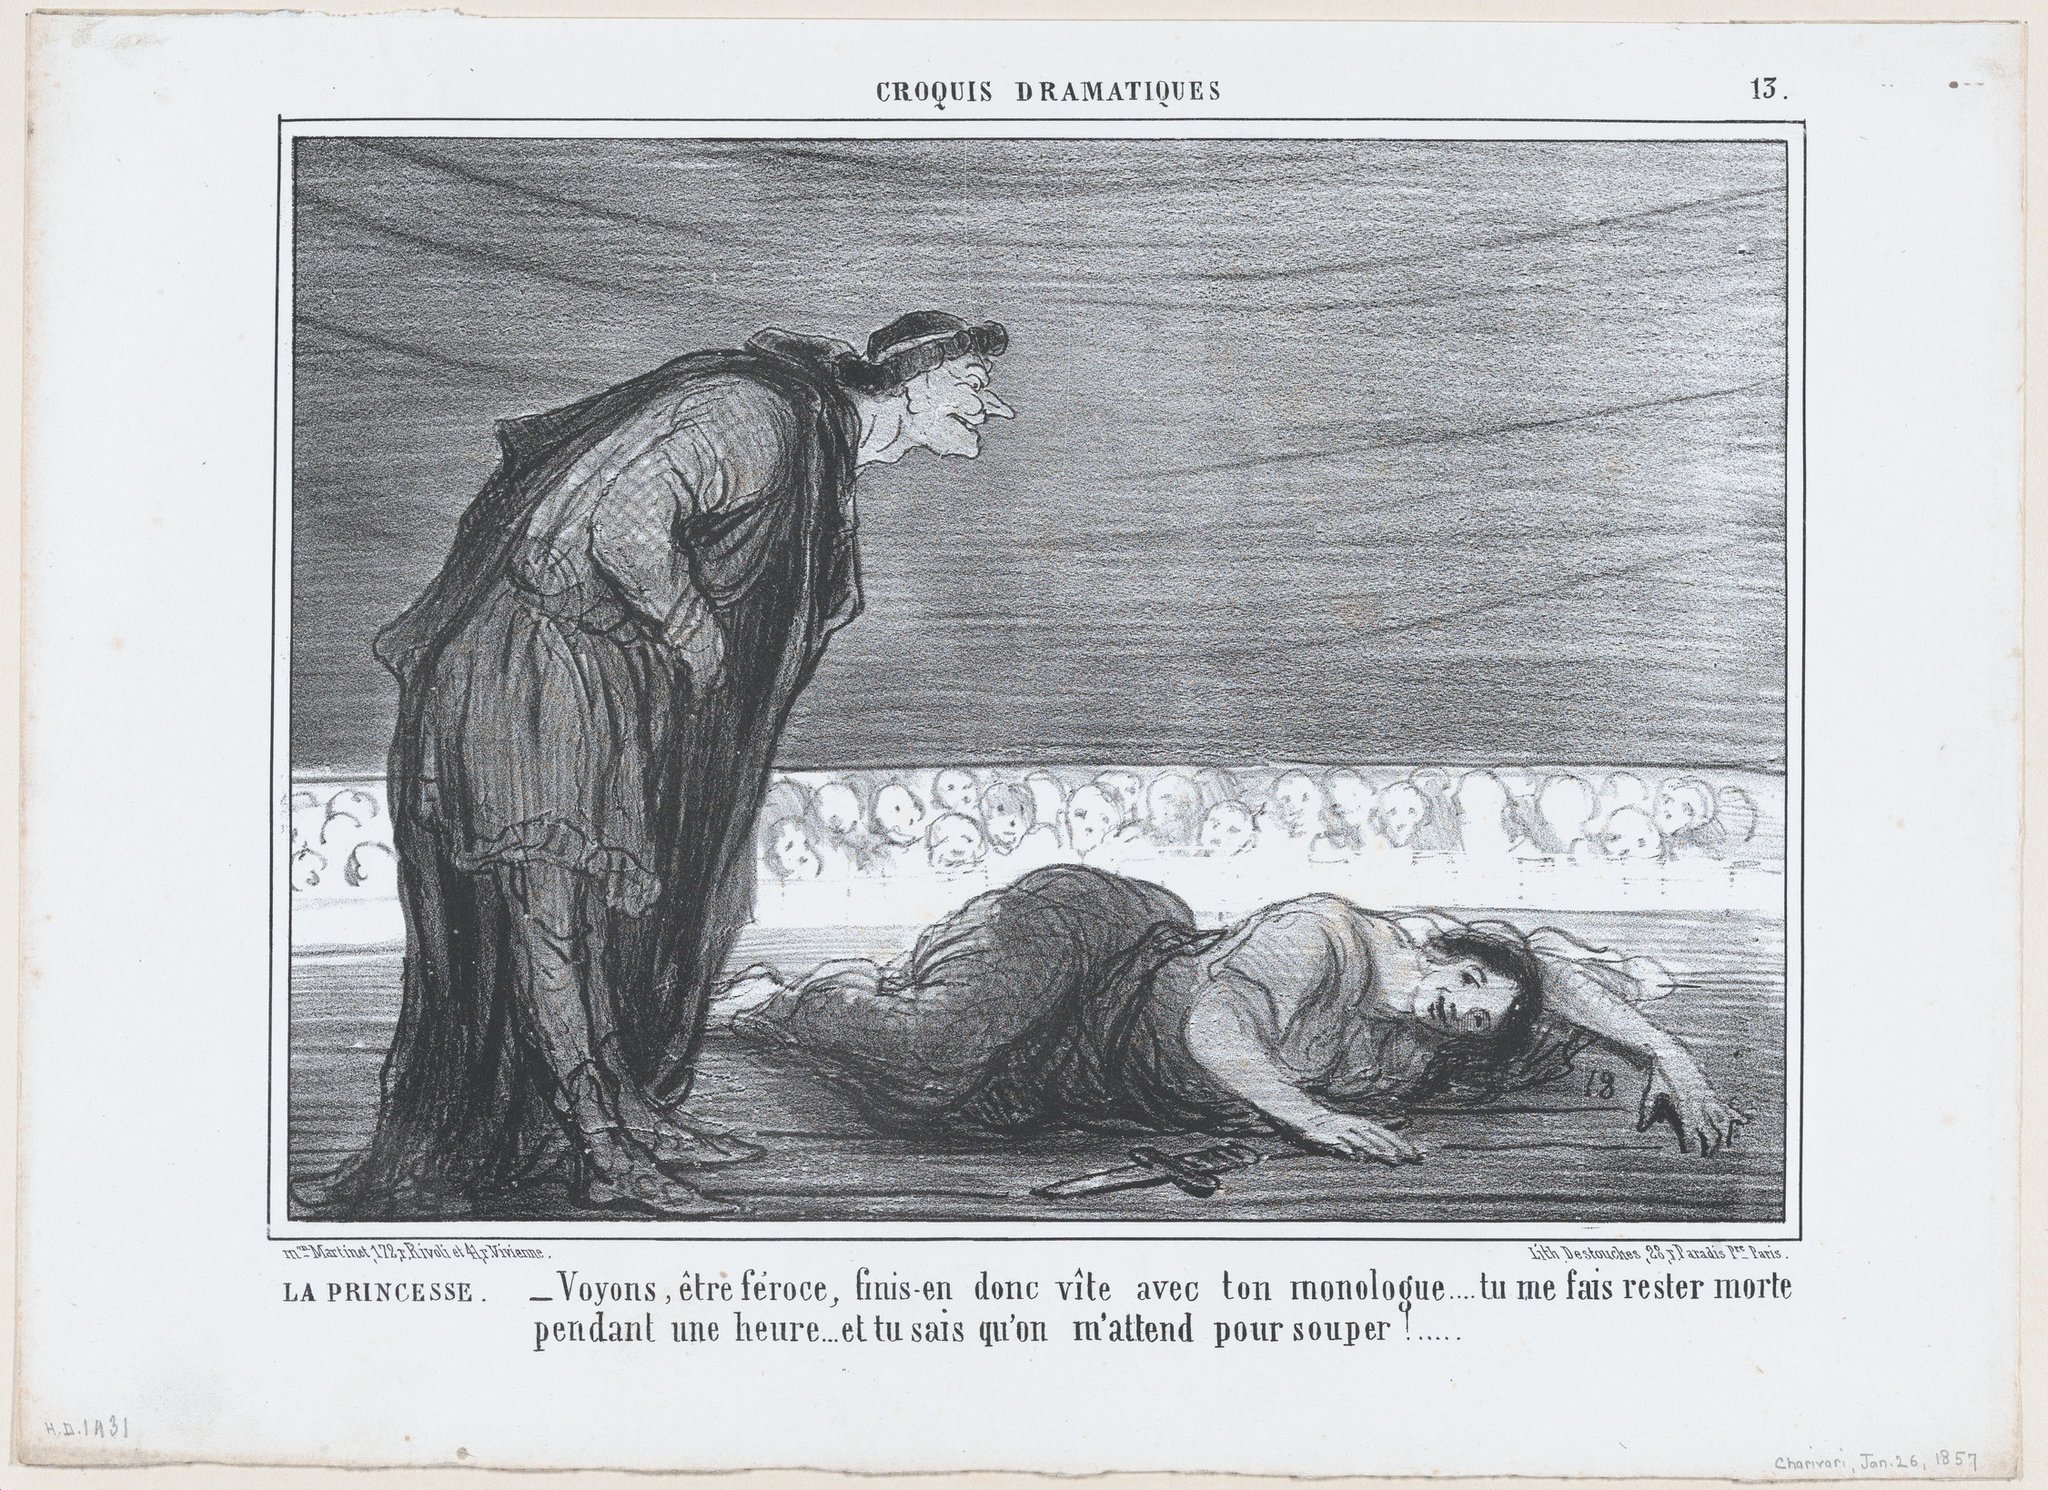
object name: print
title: La Princesse. –Voyons, être féroce, finis-en..., from Croquis Dramatiques, published in Le Charivari, January 26, 1857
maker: honoré daumier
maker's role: artist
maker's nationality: french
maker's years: 1808-1879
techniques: lithograph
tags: men,women,spectators